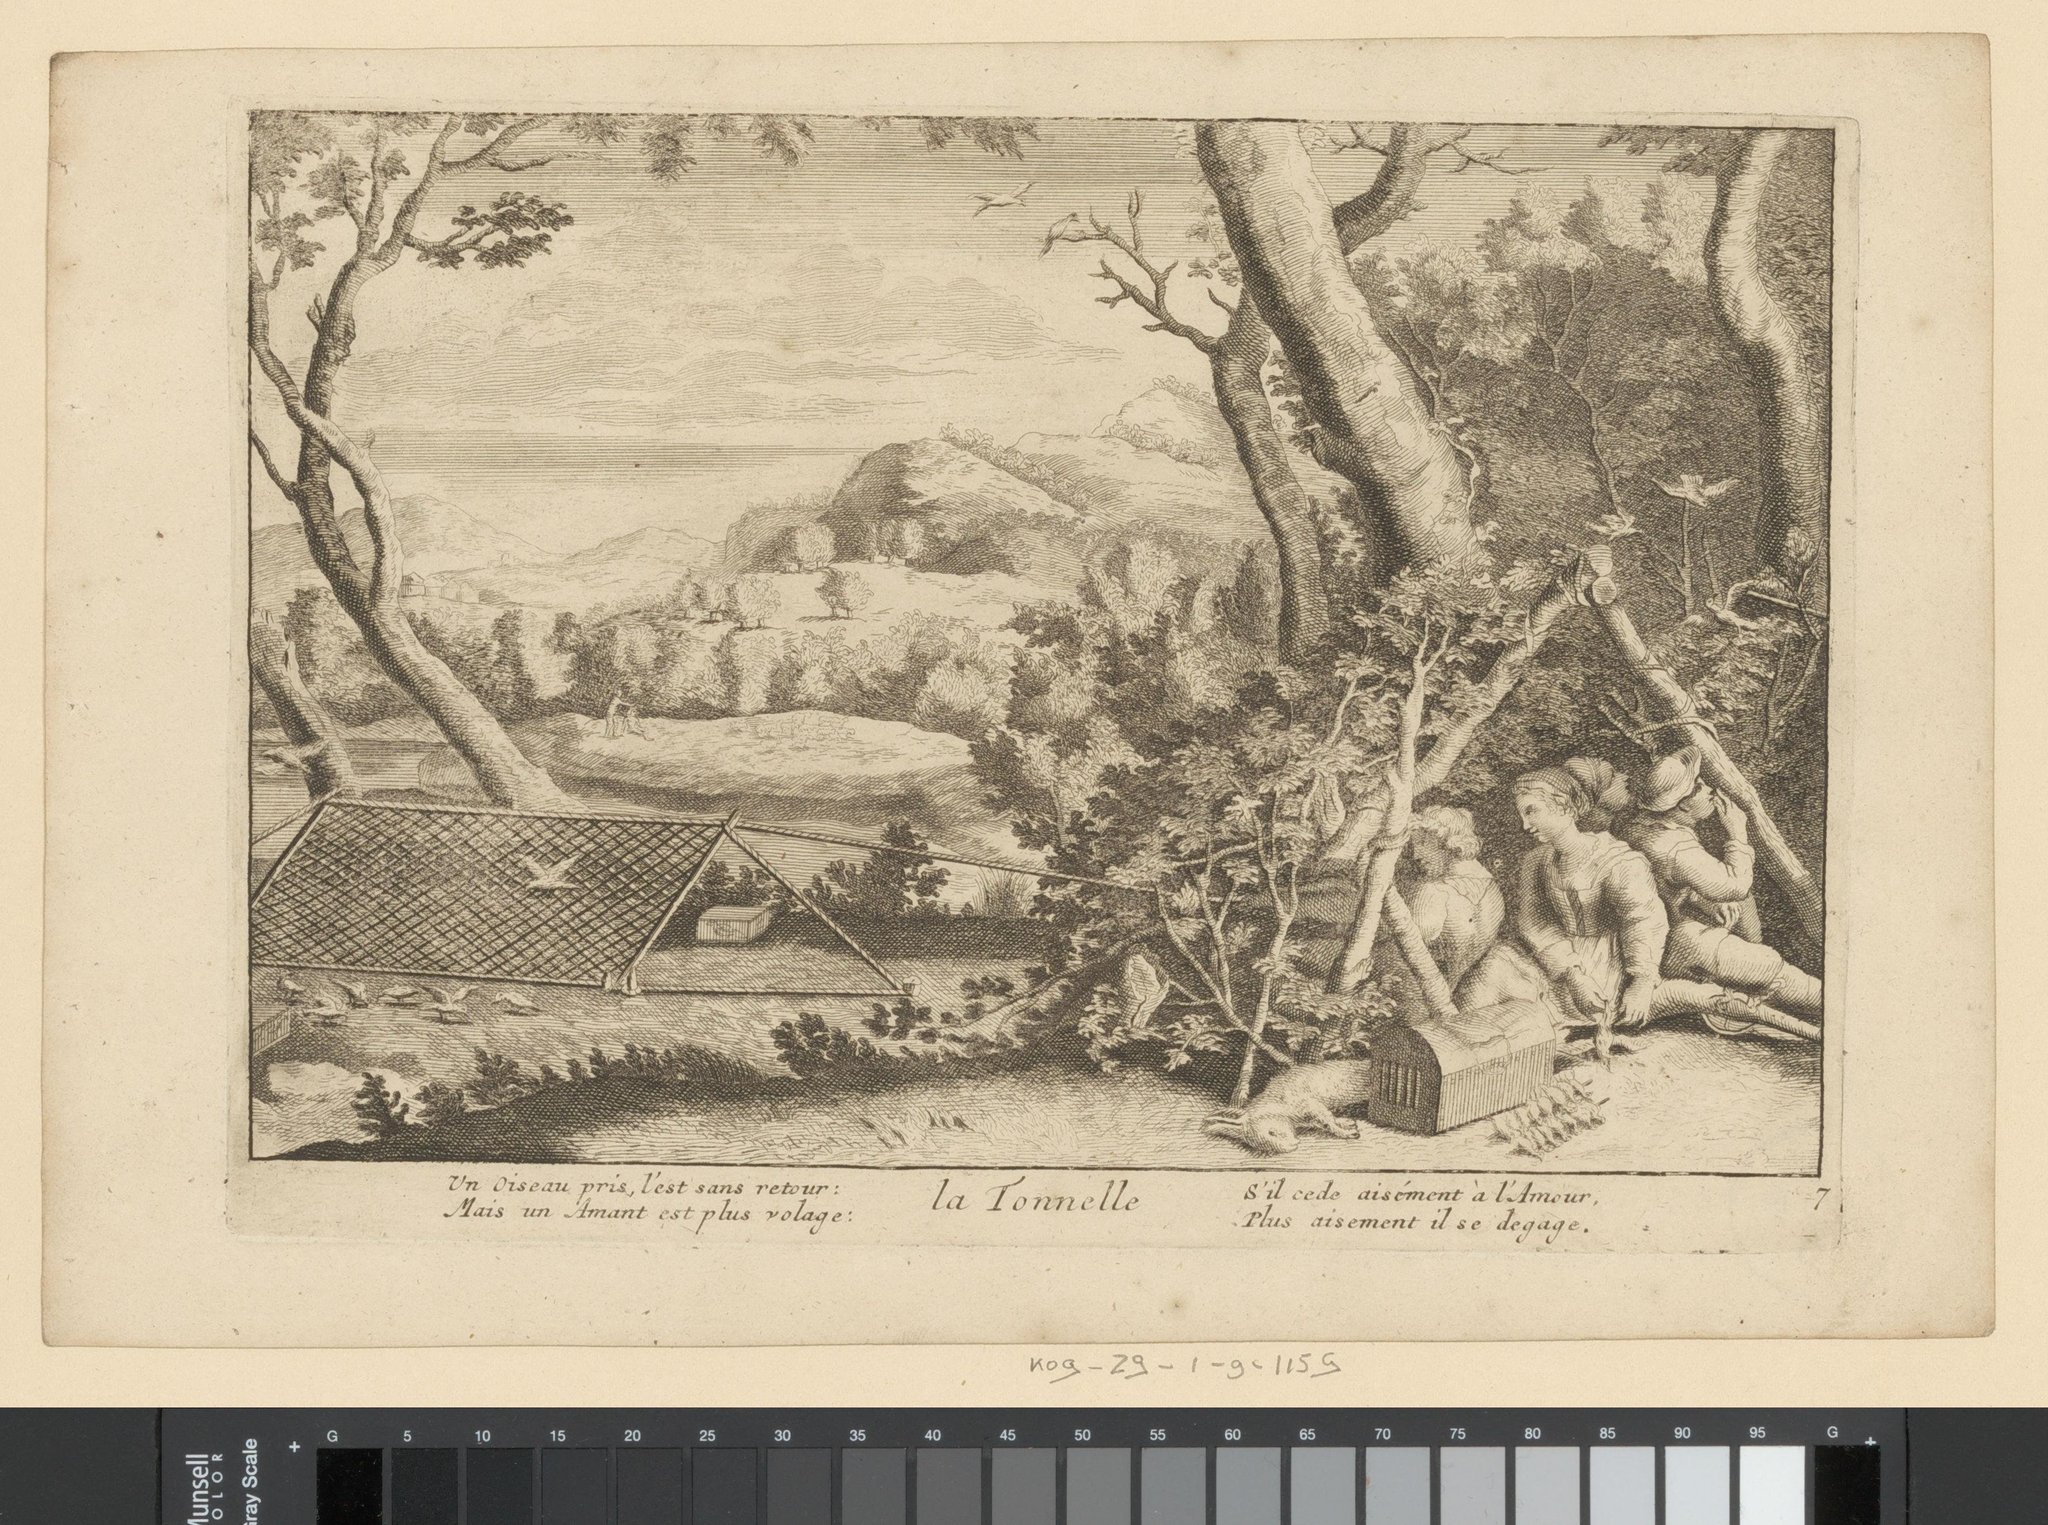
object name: print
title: Vogelvangers bij een vogelval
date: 1670-1726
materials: paper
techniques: engraving, etching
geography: amsterdam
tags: fowling, fowler, finch trap, finchery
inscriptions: collector's mark: Lugt 1641, collector's mark: Lugt 1641, stamp:, stamp:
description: Genummerd rechtsonder: 7. Onderwerpsrubrieken binnen de Atlas Zeden en Gewoonten: Handel, nijverheid en verkeer, Boerenleven.